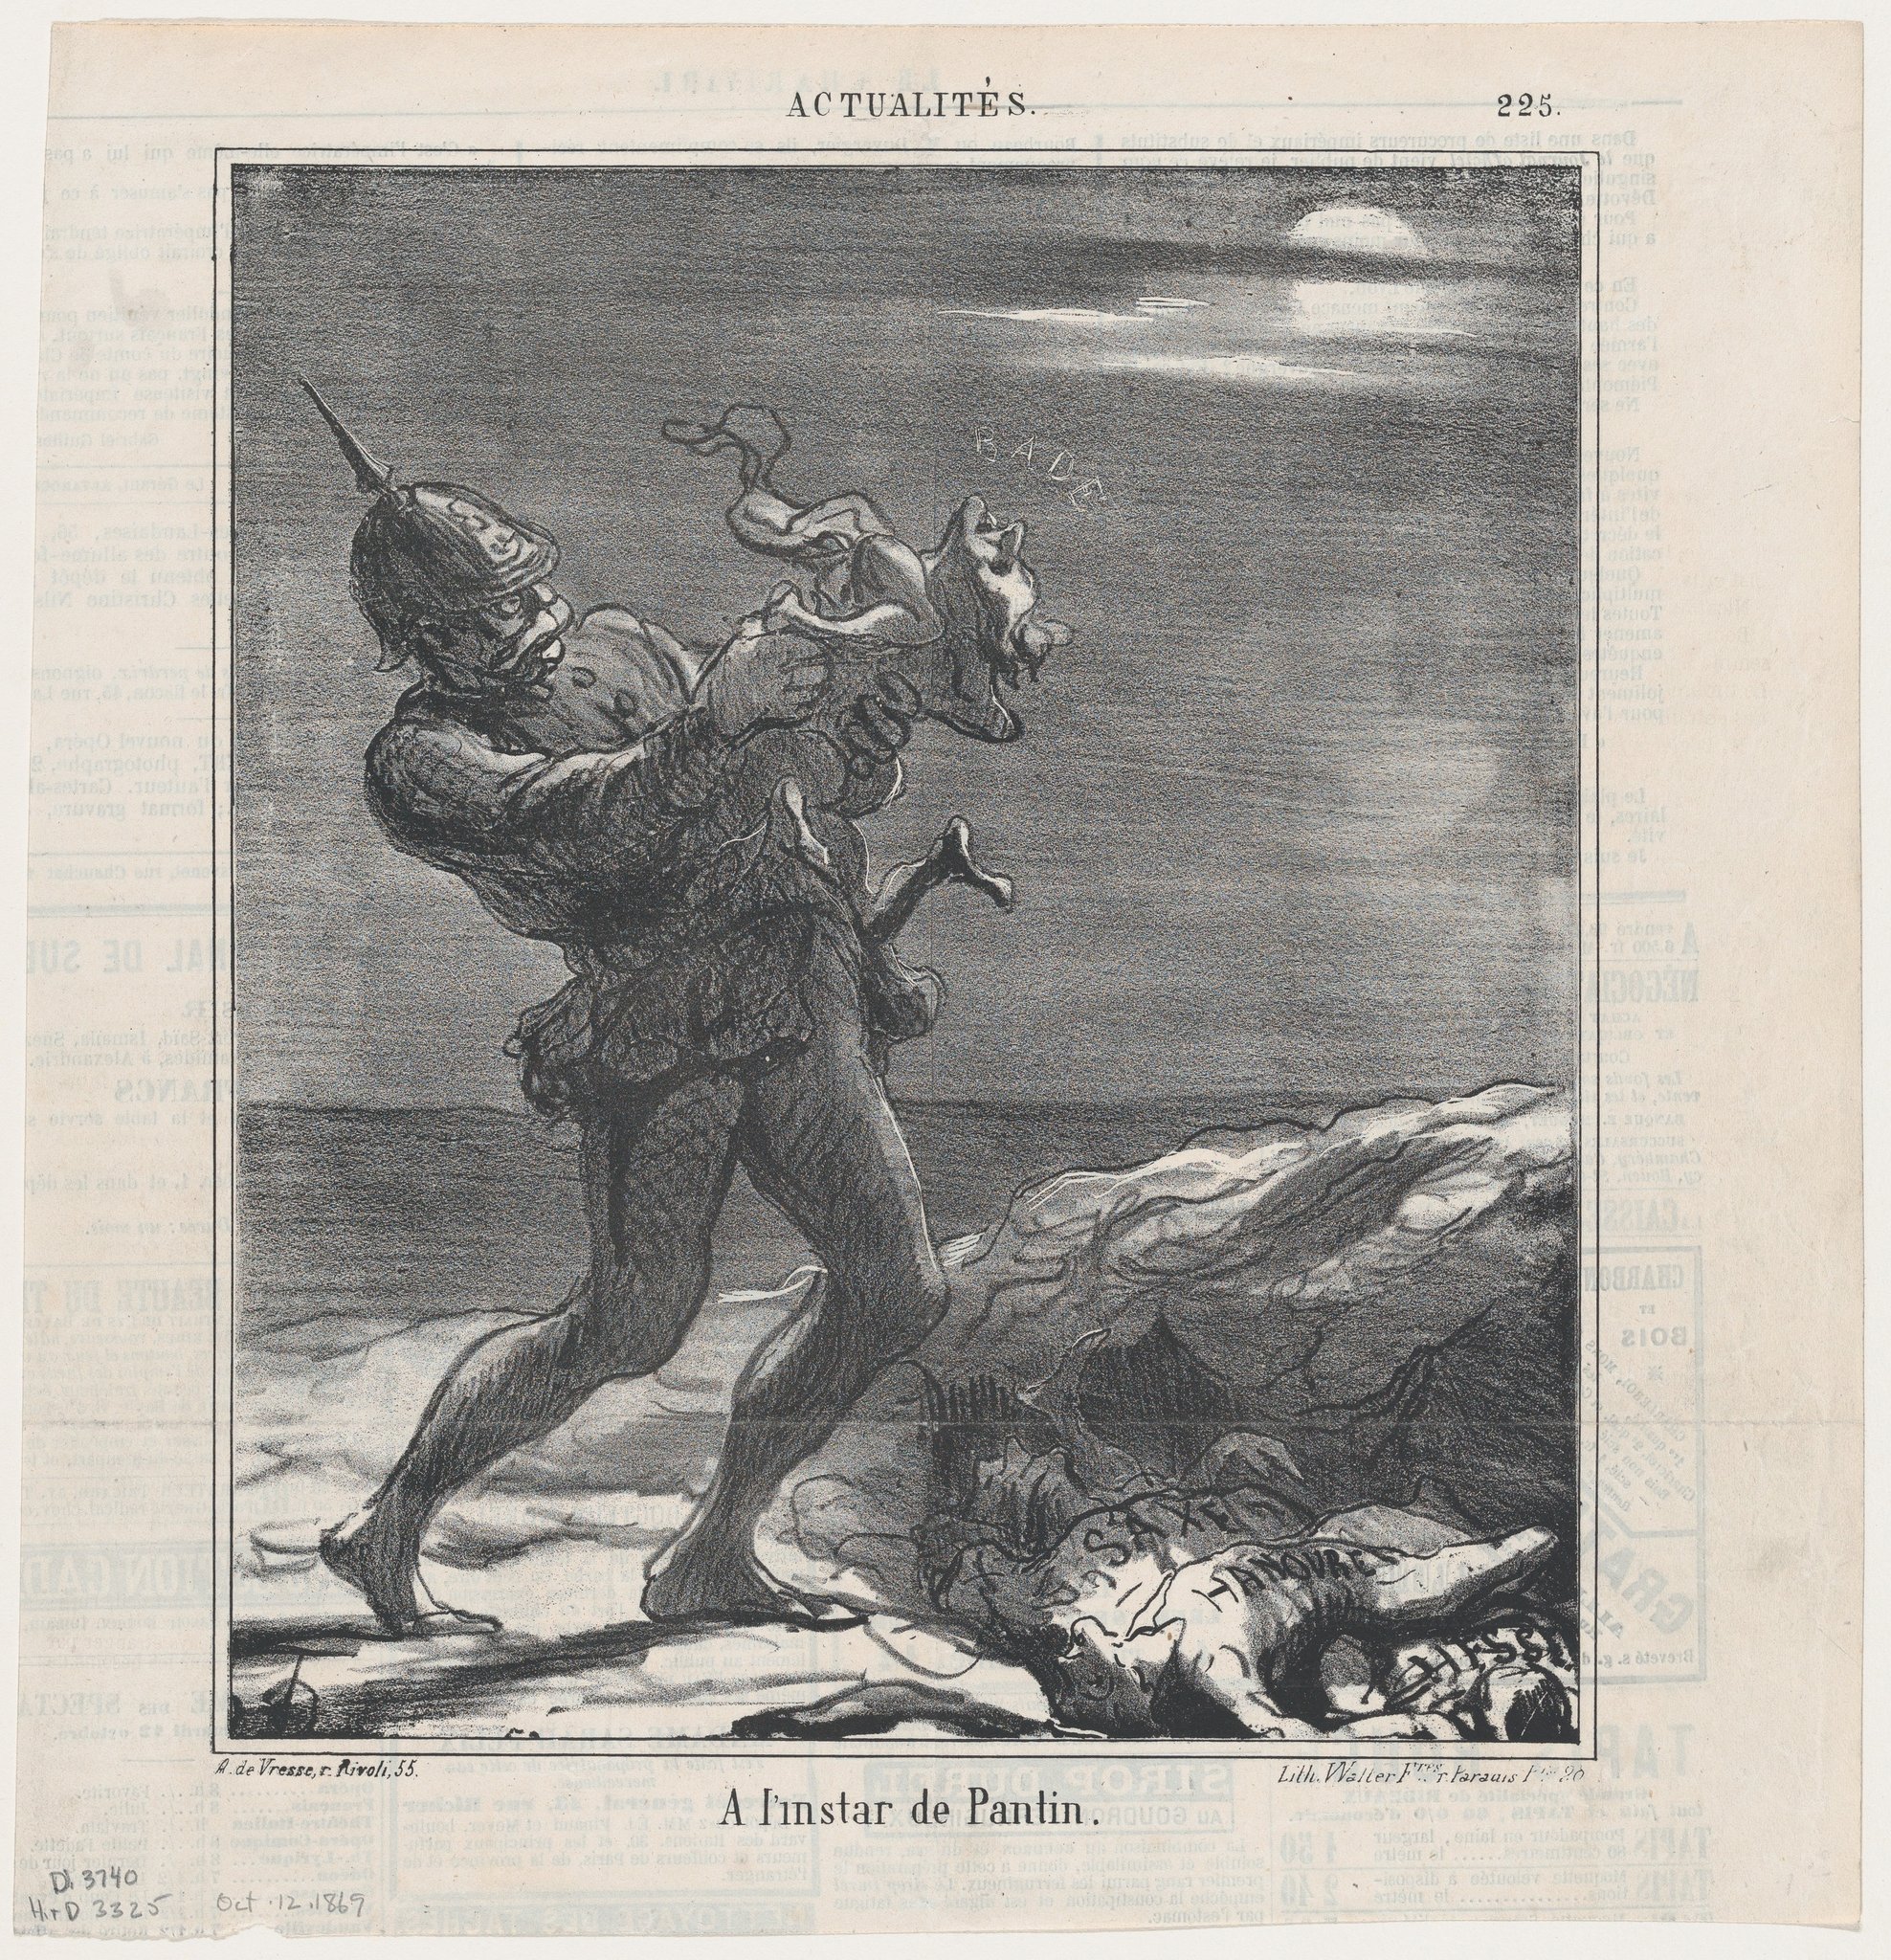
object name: print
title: Like a Puppet, from 'News of the day,' published in Le Charivari, October 12, 1869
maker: honoré daumier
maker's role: artist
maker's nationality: french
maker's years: 1808-1879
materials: paper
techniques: lithograph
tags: satire,soldiers,men